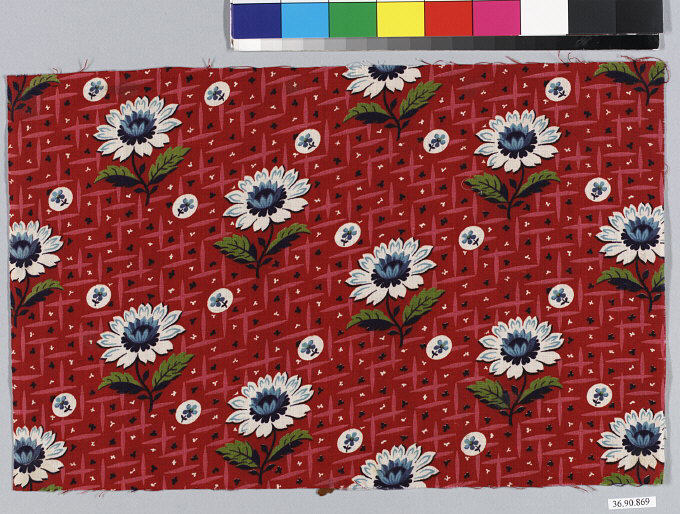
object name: piece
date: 1801-1900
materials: cotton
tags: flowers,leaves